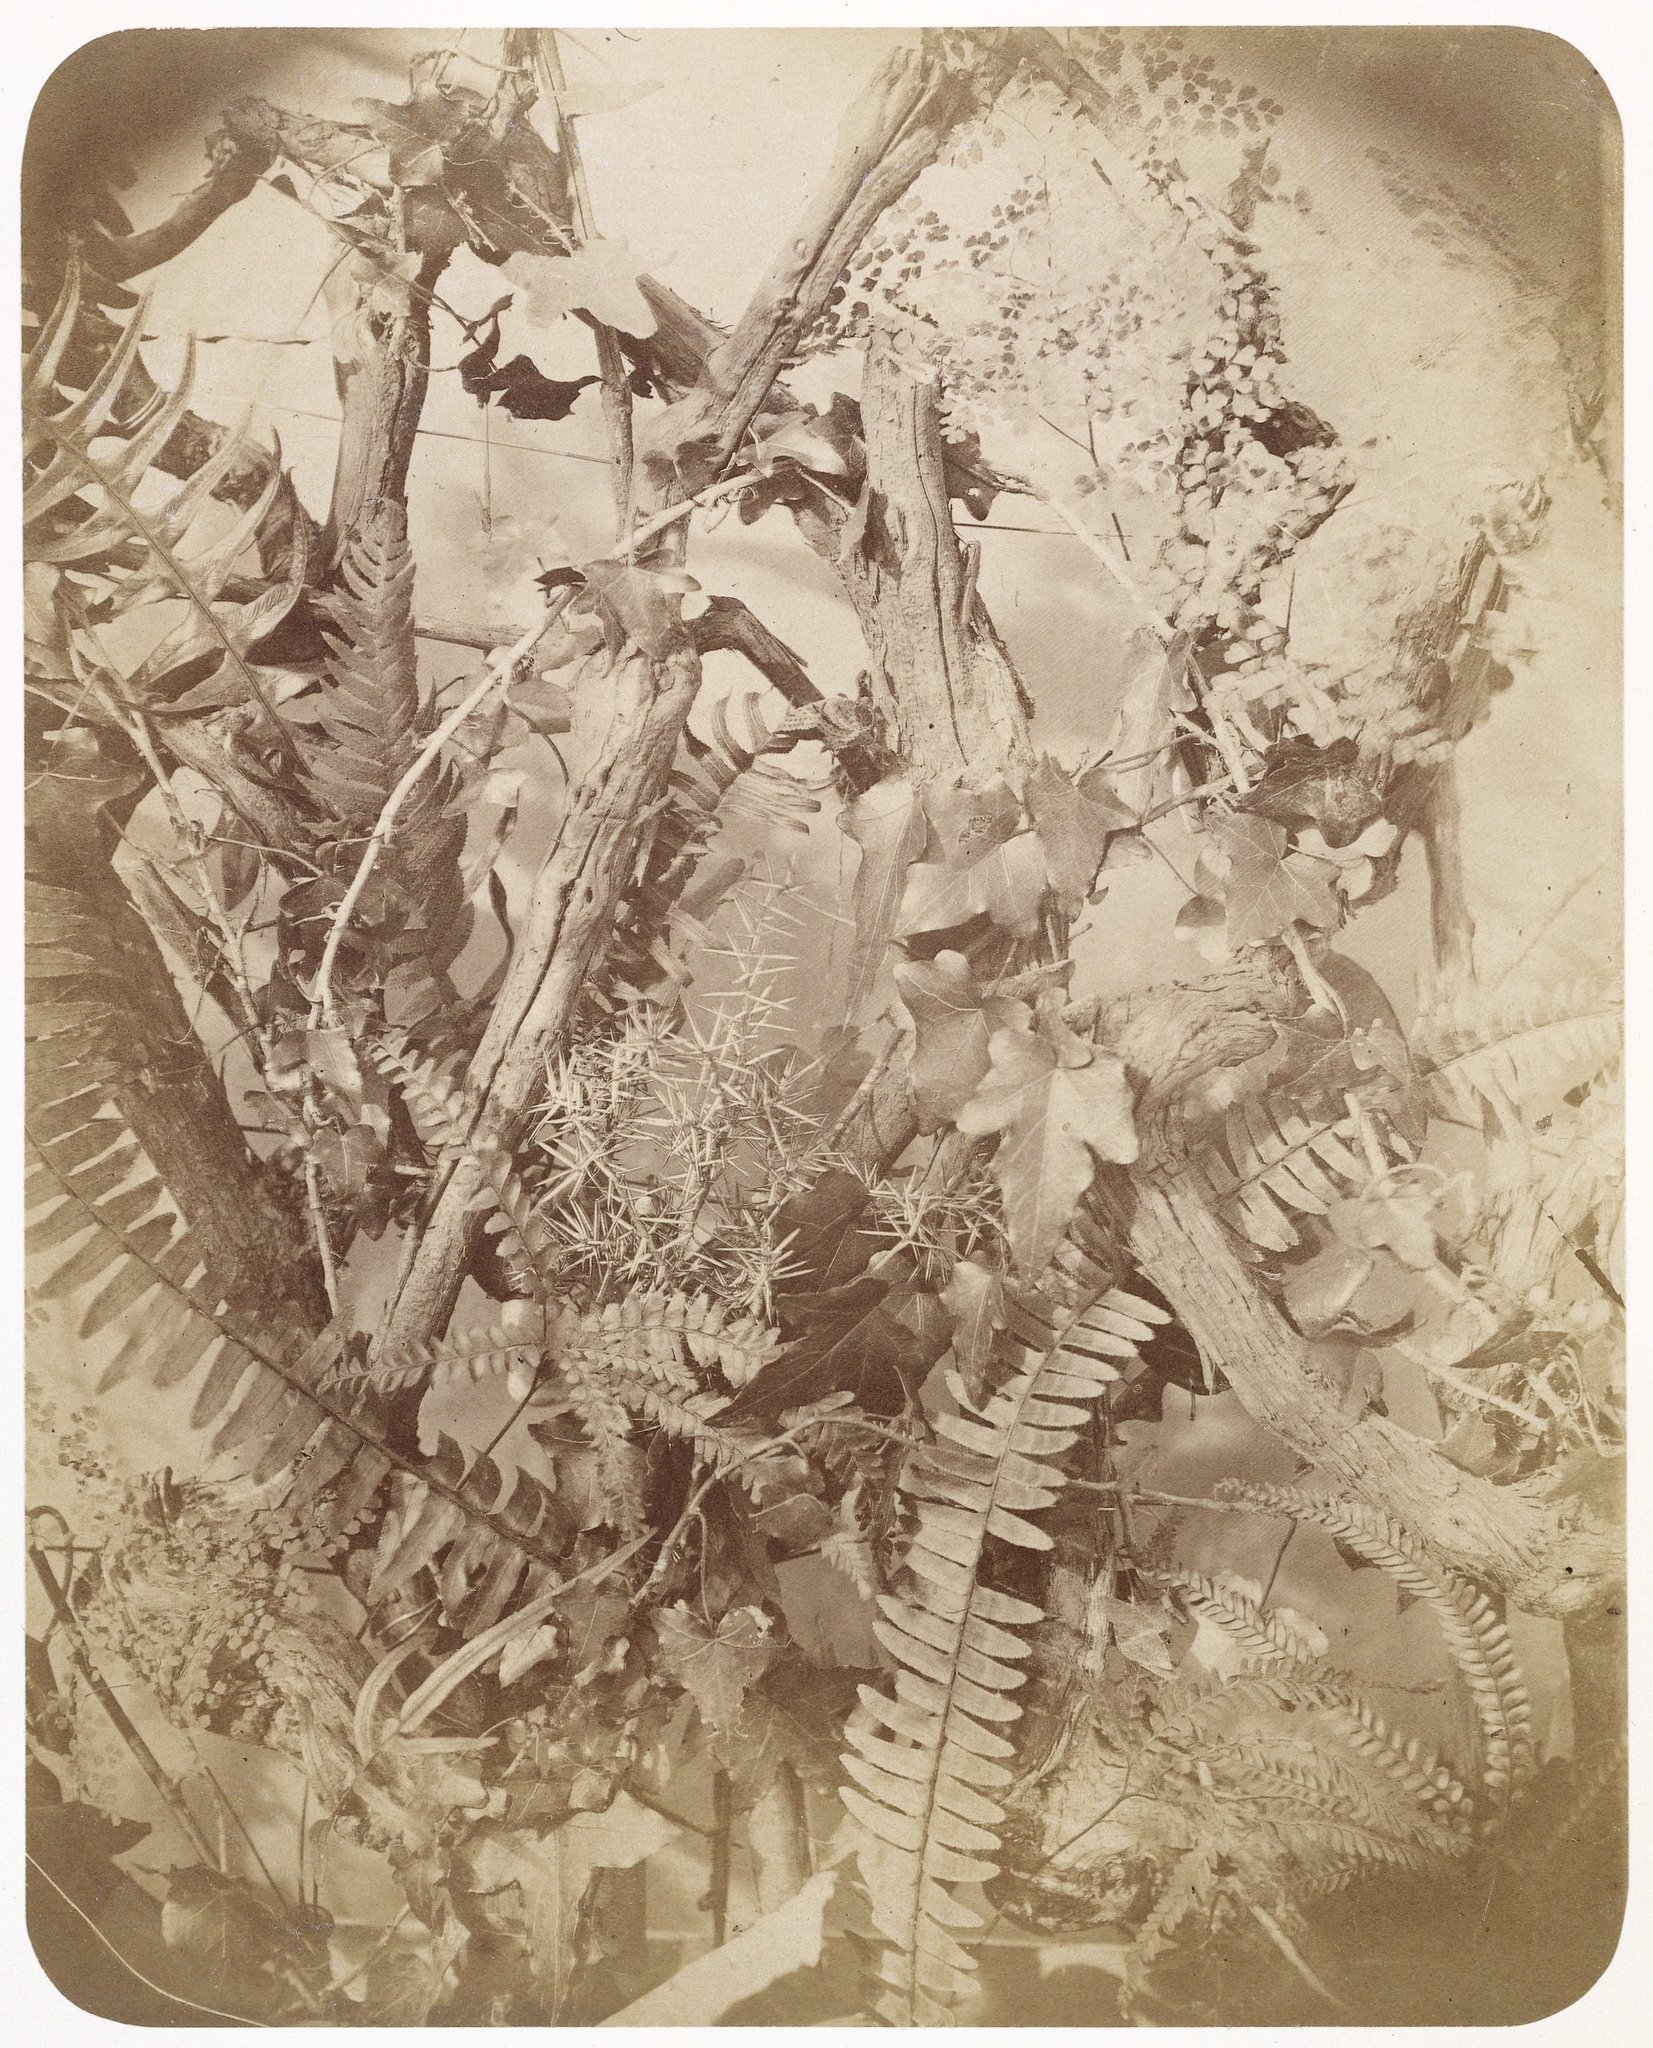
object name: photograph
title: Stilleven met takken en varens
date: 1857-1860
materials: paper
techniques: albuminized salt print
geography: dornach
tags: plants (in general)